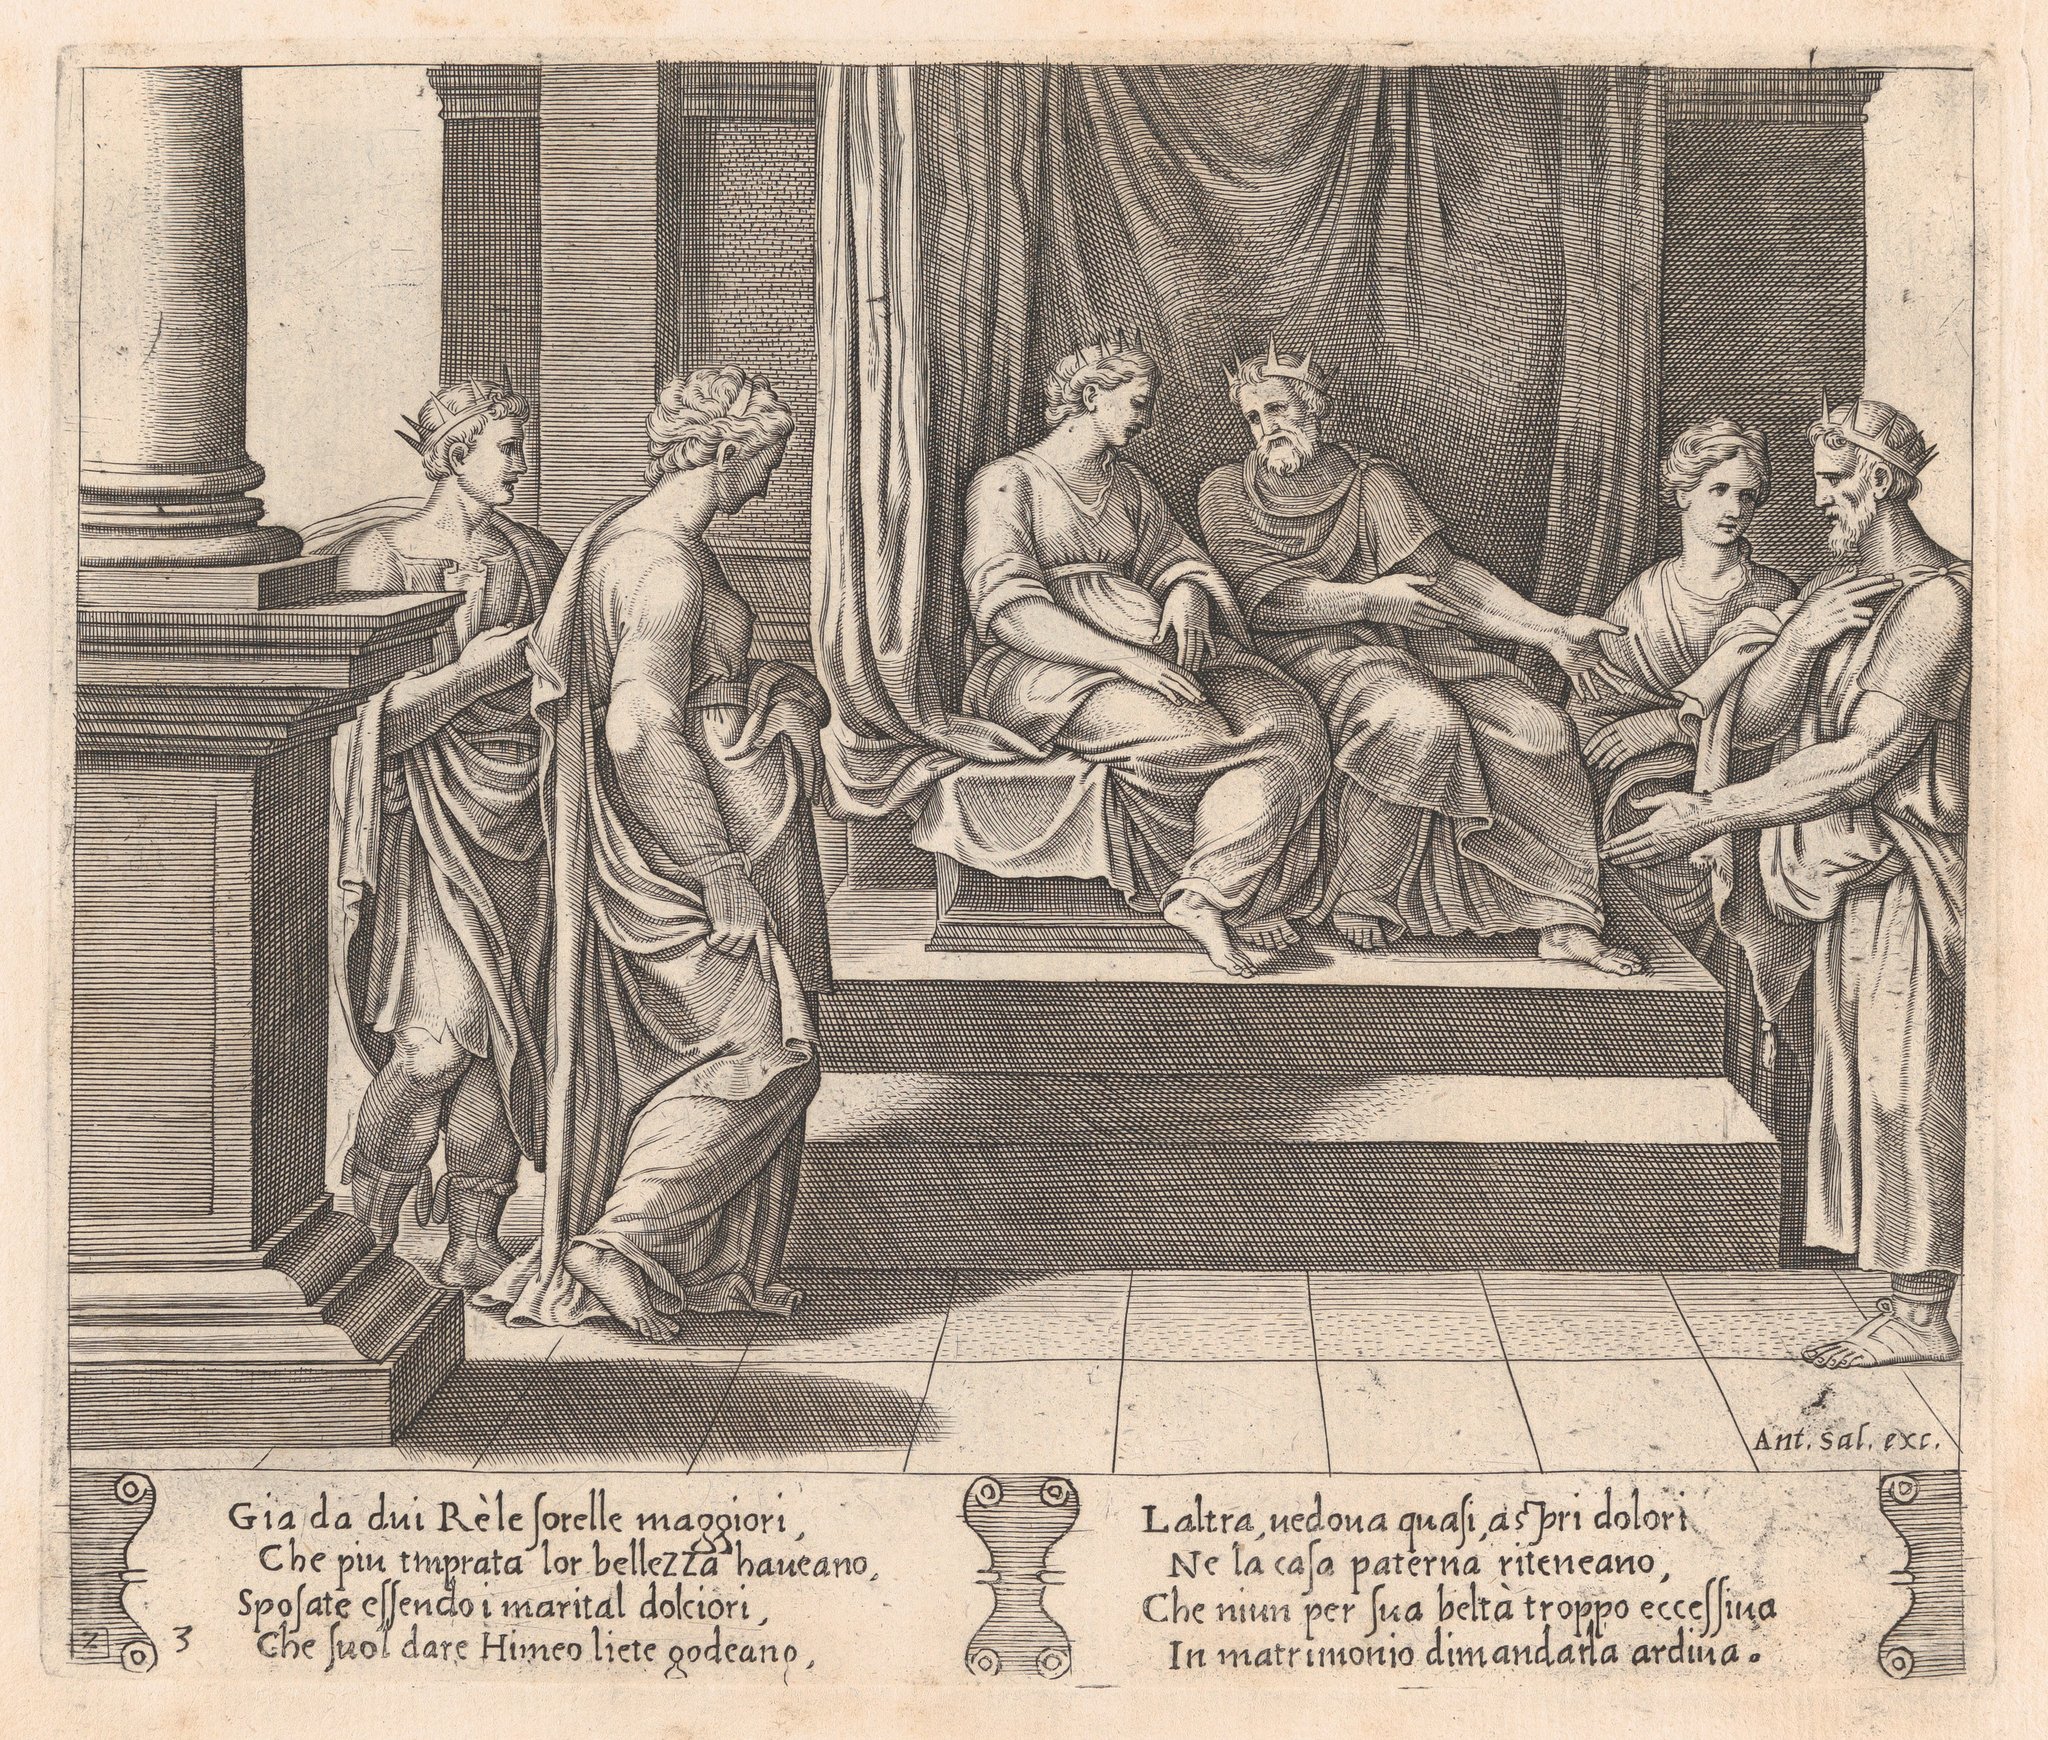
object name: print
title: Plate 3: Psyche's two sisters are married to kings, with Psyche standing at left, accompanied by another king, from "The Story of Cupid and Psyche as told by Apuleius"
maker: master of the die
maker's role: artist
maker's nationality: italian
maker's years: 1525-1560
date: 1530-1560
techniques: engraving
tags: kings,men,women,psyche,ceremony